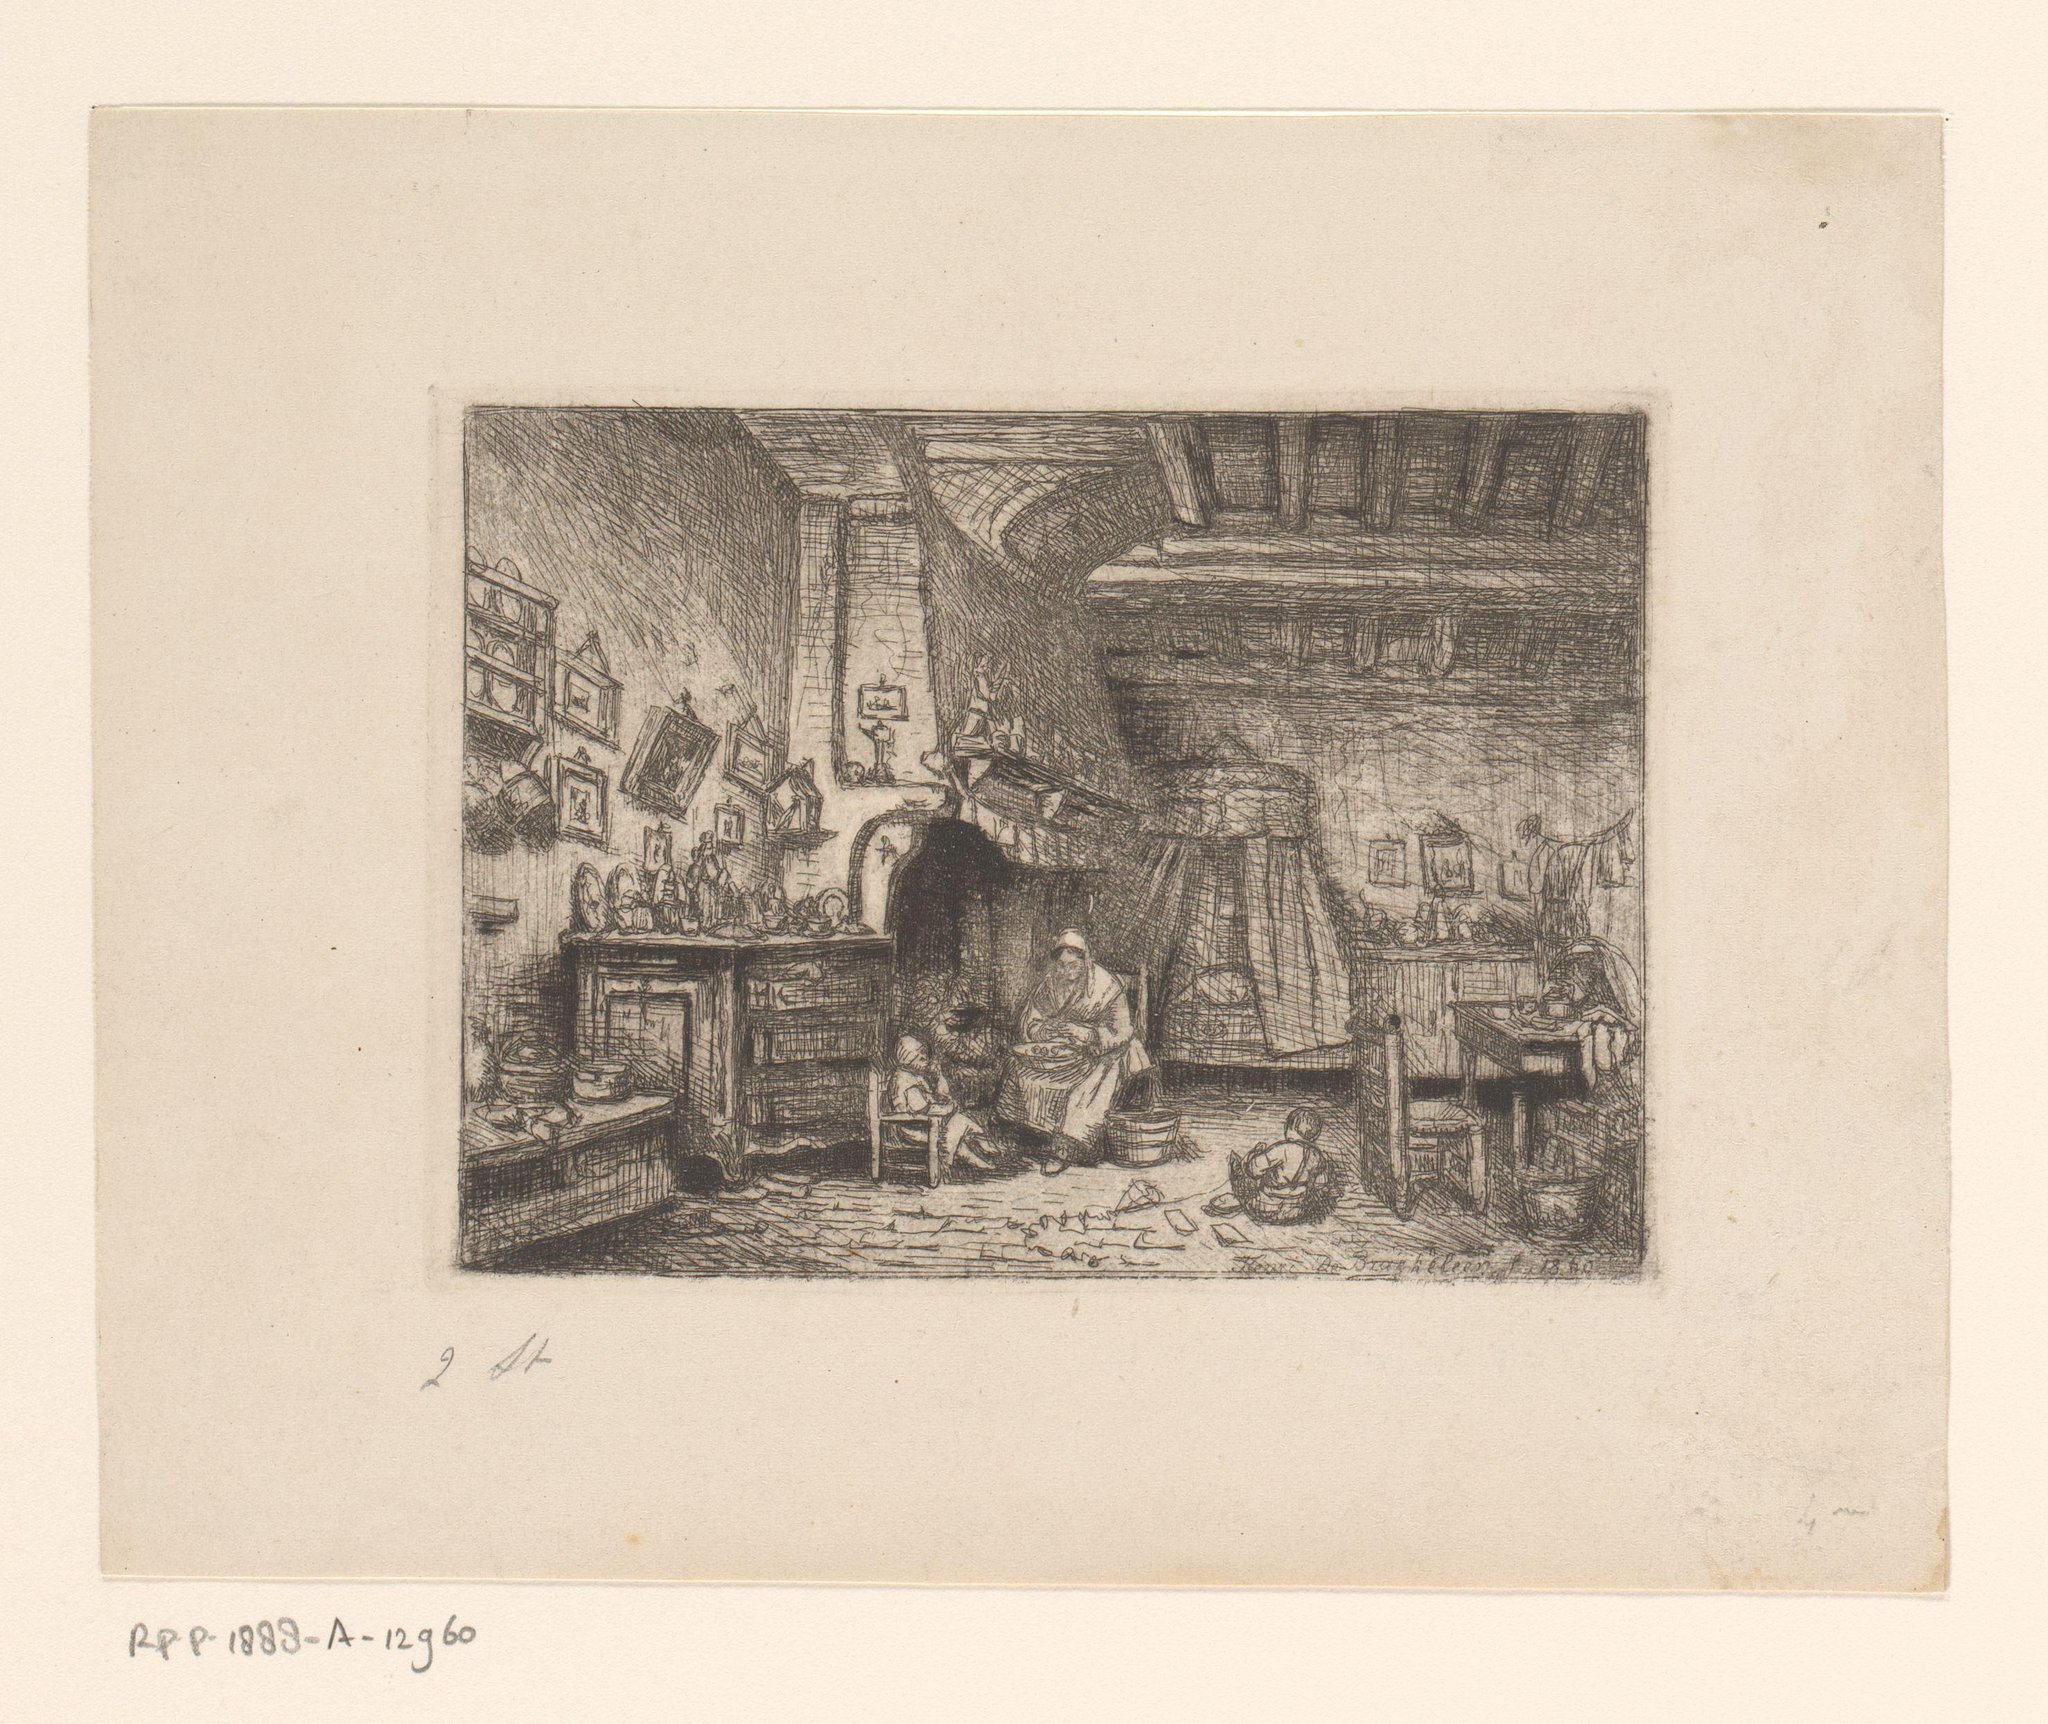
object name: print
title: Interieur met een vrouw en twee kinderen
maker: henri de braekeleer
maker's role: draughtsman, print maker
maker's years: 1840-1888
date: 1860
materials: paper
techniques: drypoint, etching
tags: adult woman, mother and baby or young child, (flying a) kite, interior ~ representation of a building, child (at home)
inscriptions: collector's mark: Lugt 2228